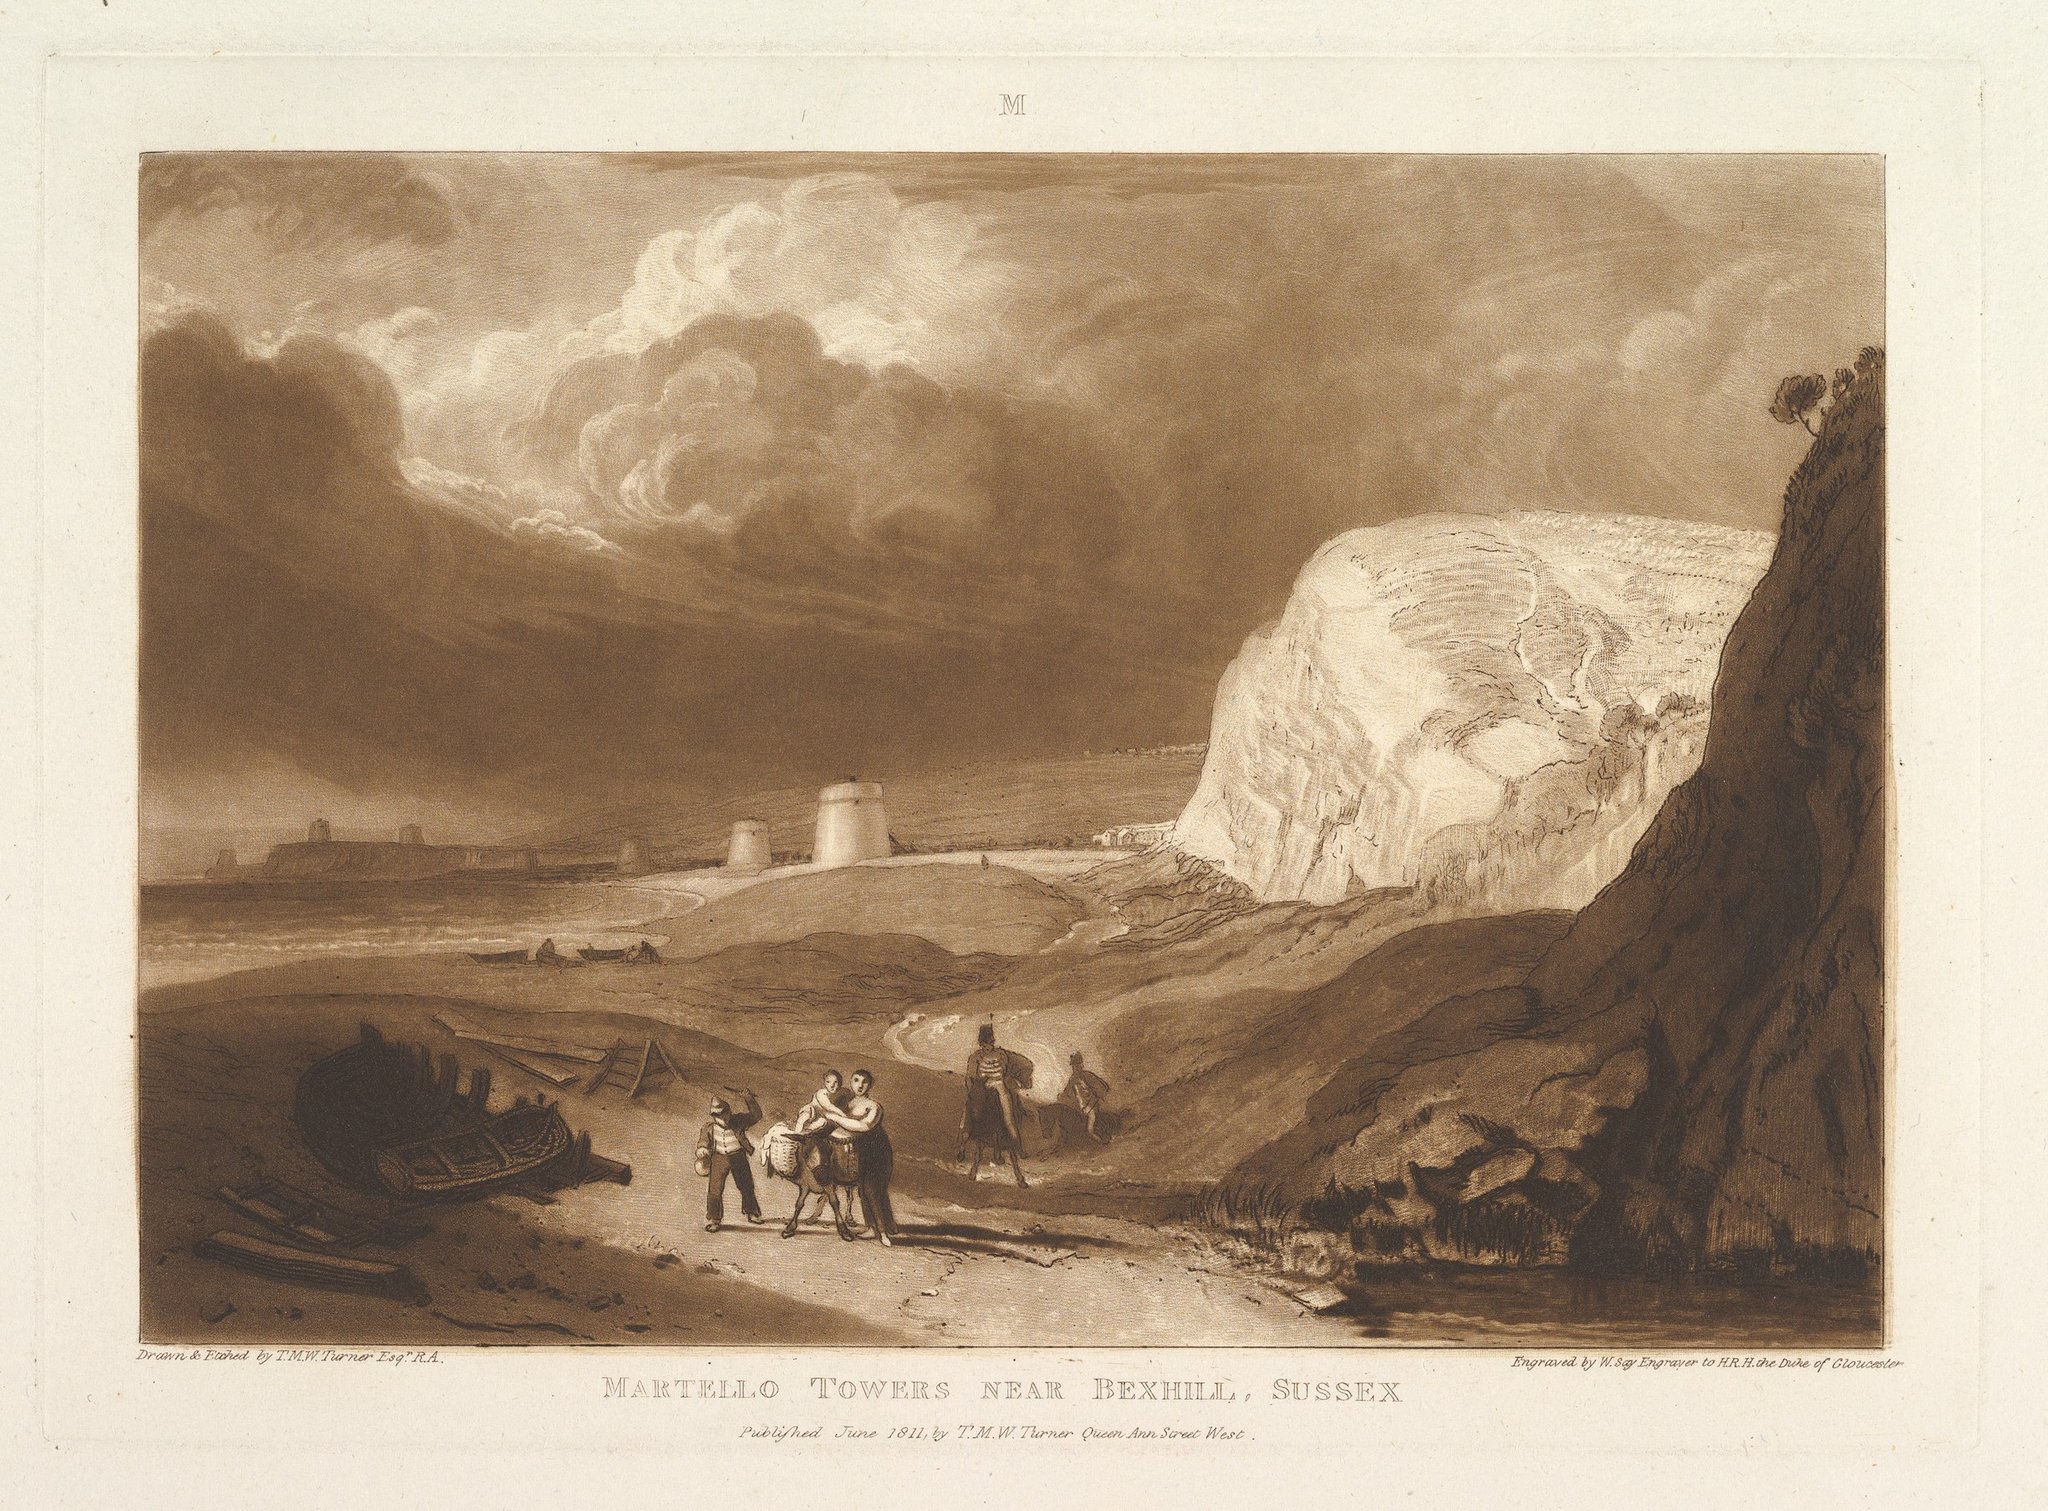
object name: print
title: Martello Towers near Bexhill, Sussex, part VII, plate 34 from "Liber Studiorum"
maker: joseph mallord william turner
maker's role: artist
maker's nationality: british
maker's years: 1775-1851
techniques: etching, mezzotint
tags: towers,men,women,landscapes,boats